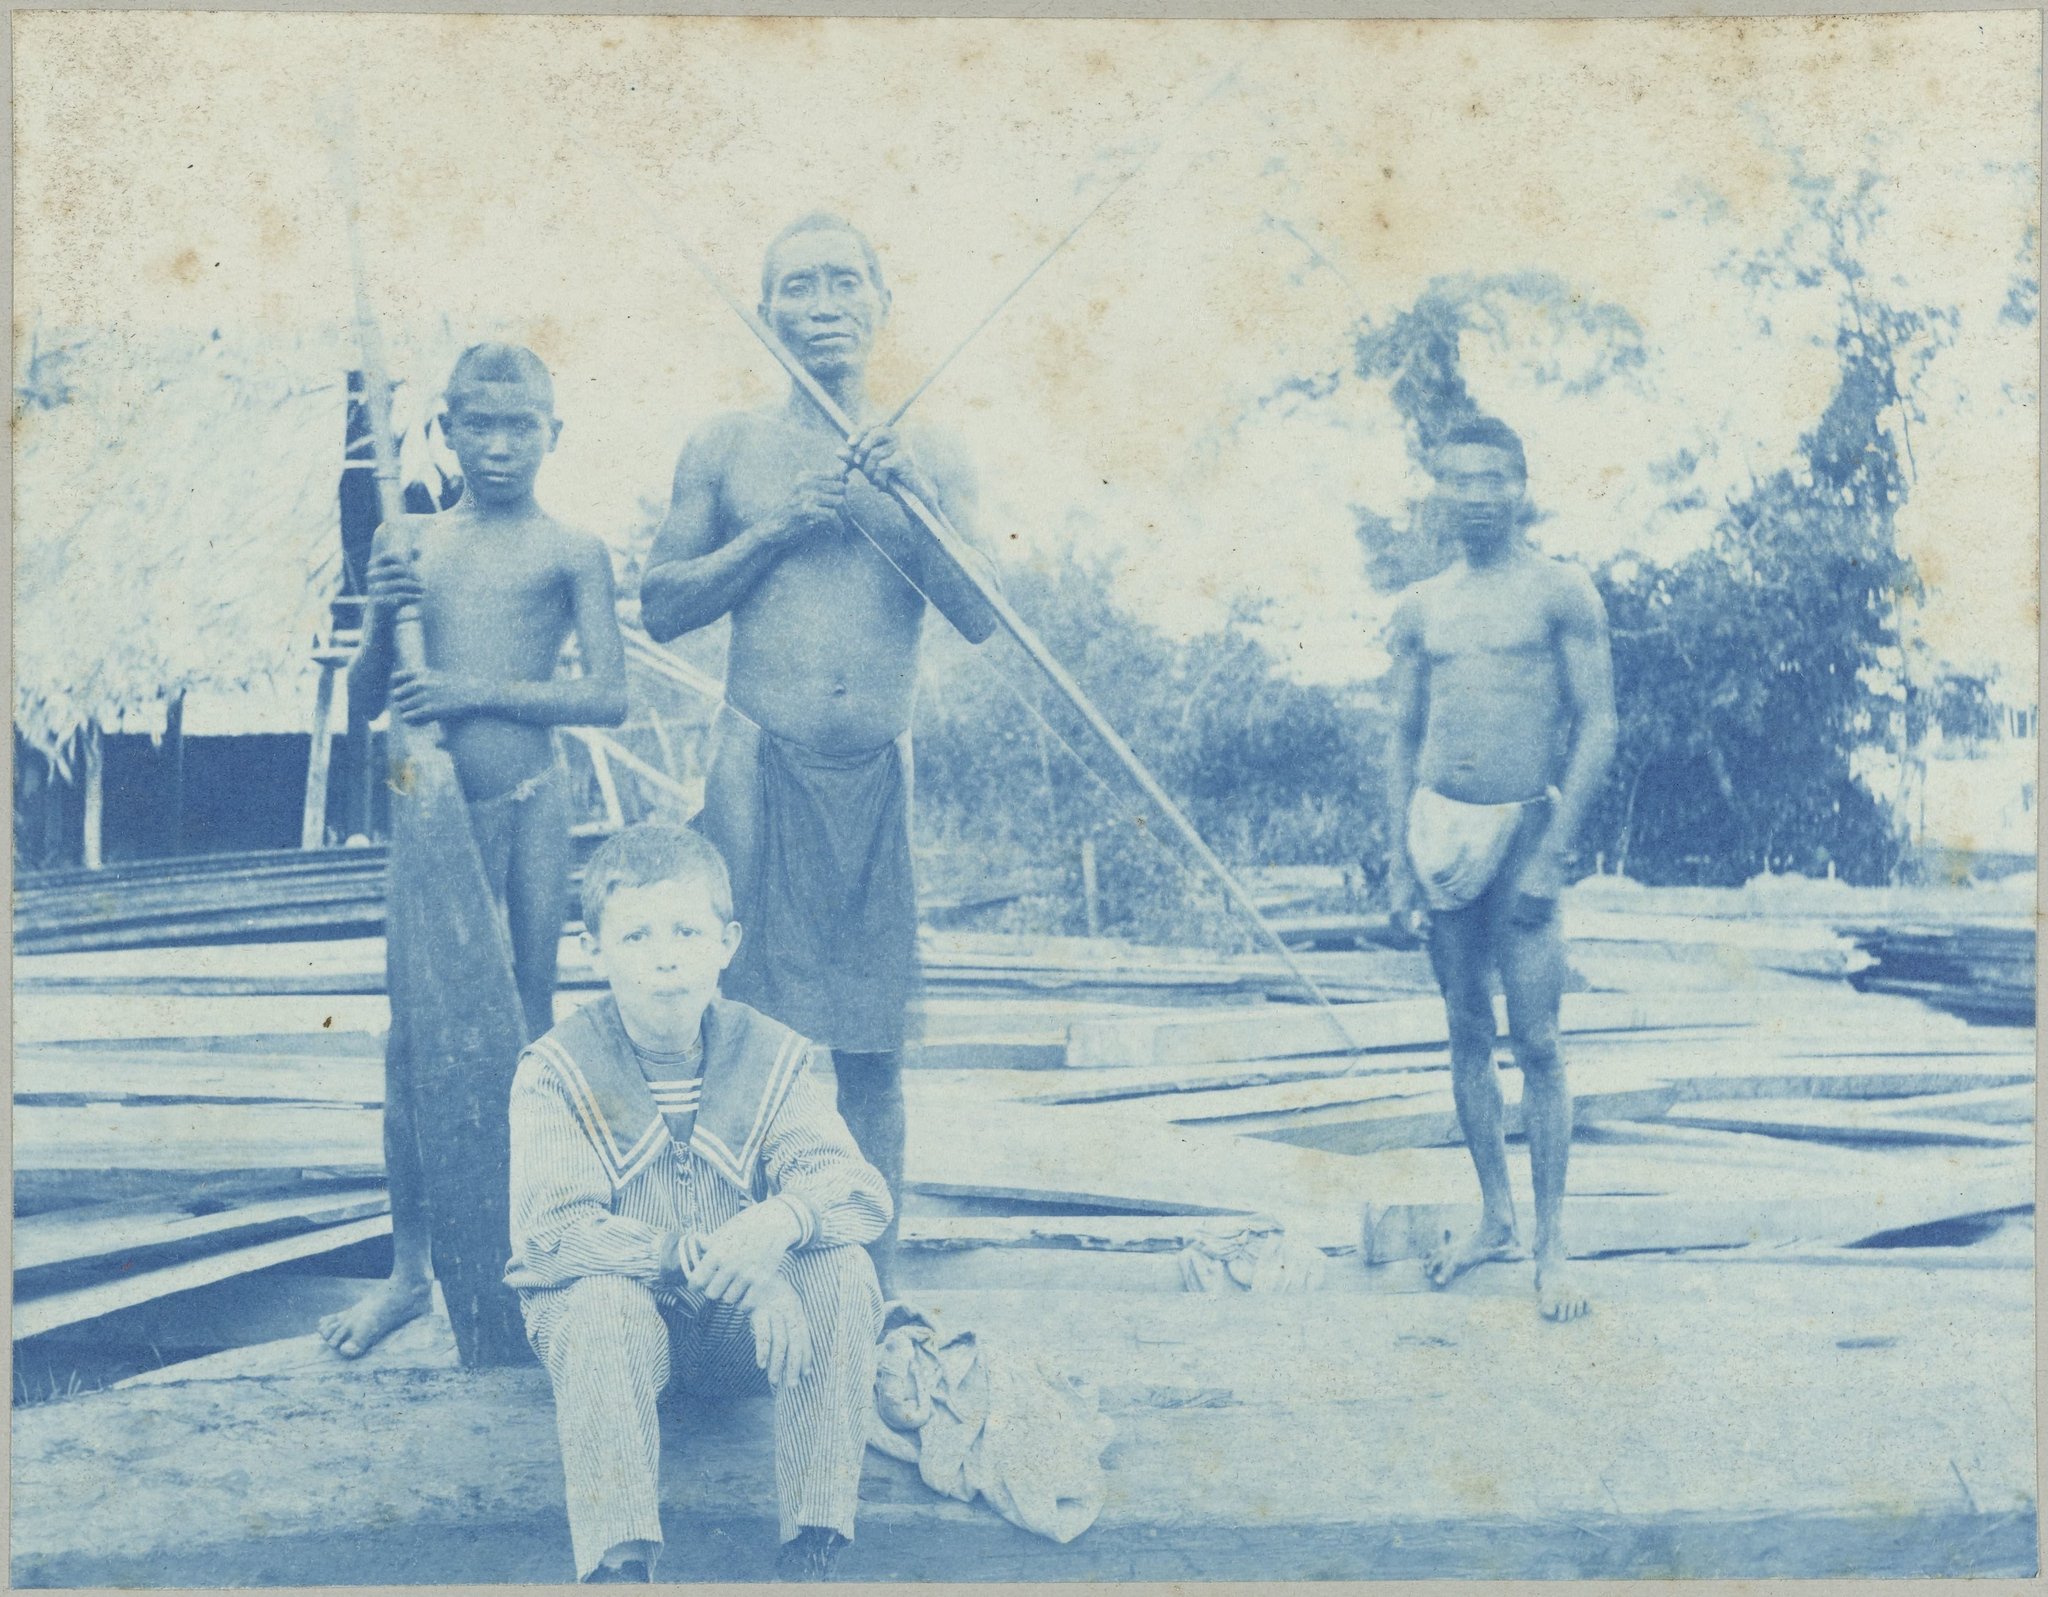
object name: photograph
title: Anton met drie Marrons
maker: hendrik doijer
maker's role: engineer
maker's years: 1863-1925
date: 1903-1910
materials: photographic support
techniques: cyanotype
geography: suriname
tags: suriname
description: Een Nederlandse jongen Anton zittend poserend voor een groep van drie Marrons, met roeispaan en pijl en boog. Onderdeel van het fotoalbum Souvenir de Voyage (deel 1), over het leven van de familie Doijer in en rond de plantage Ma Retraite in Suriname in de jaren 1903-1910.